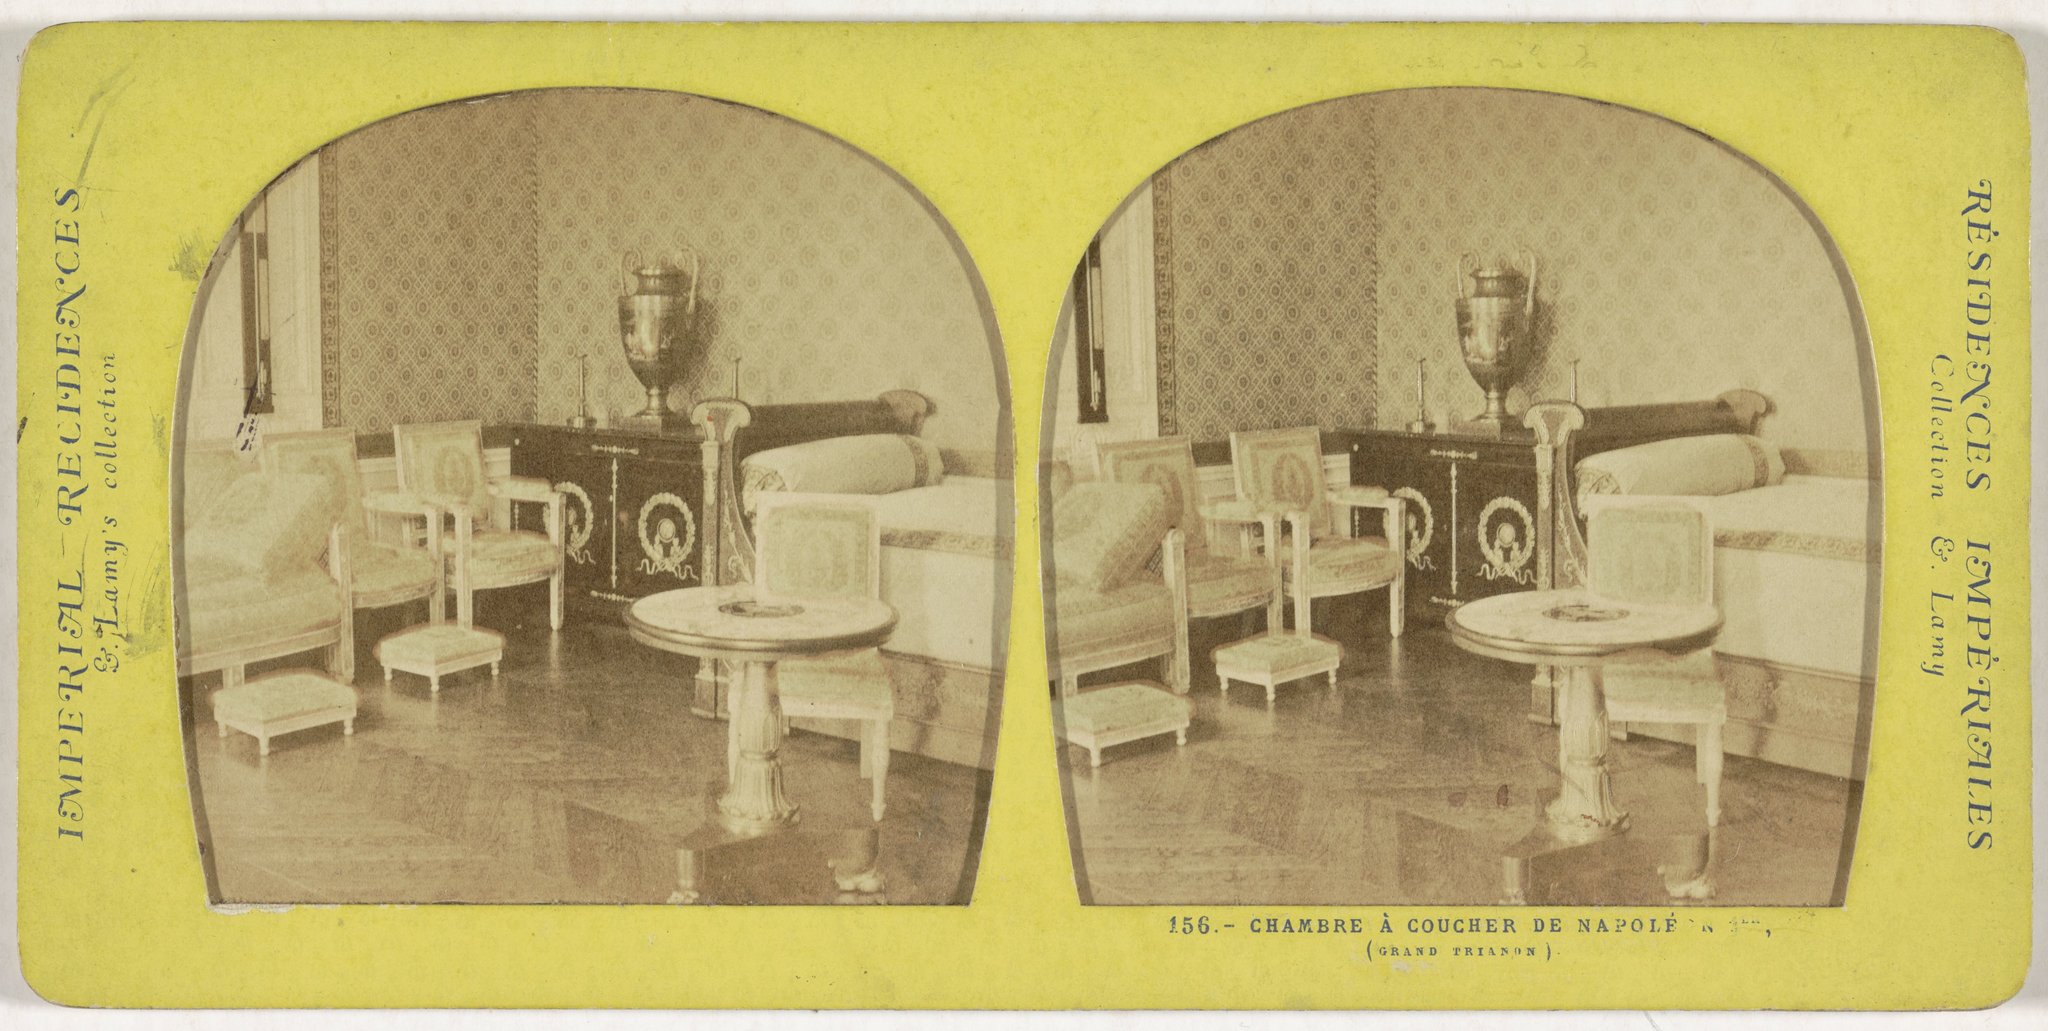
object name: stereograph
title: 156. - Chambre à coucher de Napoléon 1er, (grand trianon)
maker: ernest eléonor pierre lamy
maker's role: publisher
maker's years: 1828-1900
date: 1860-1890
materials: cardboard, paper, photographic support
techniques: gelatin silver print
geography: netherlands